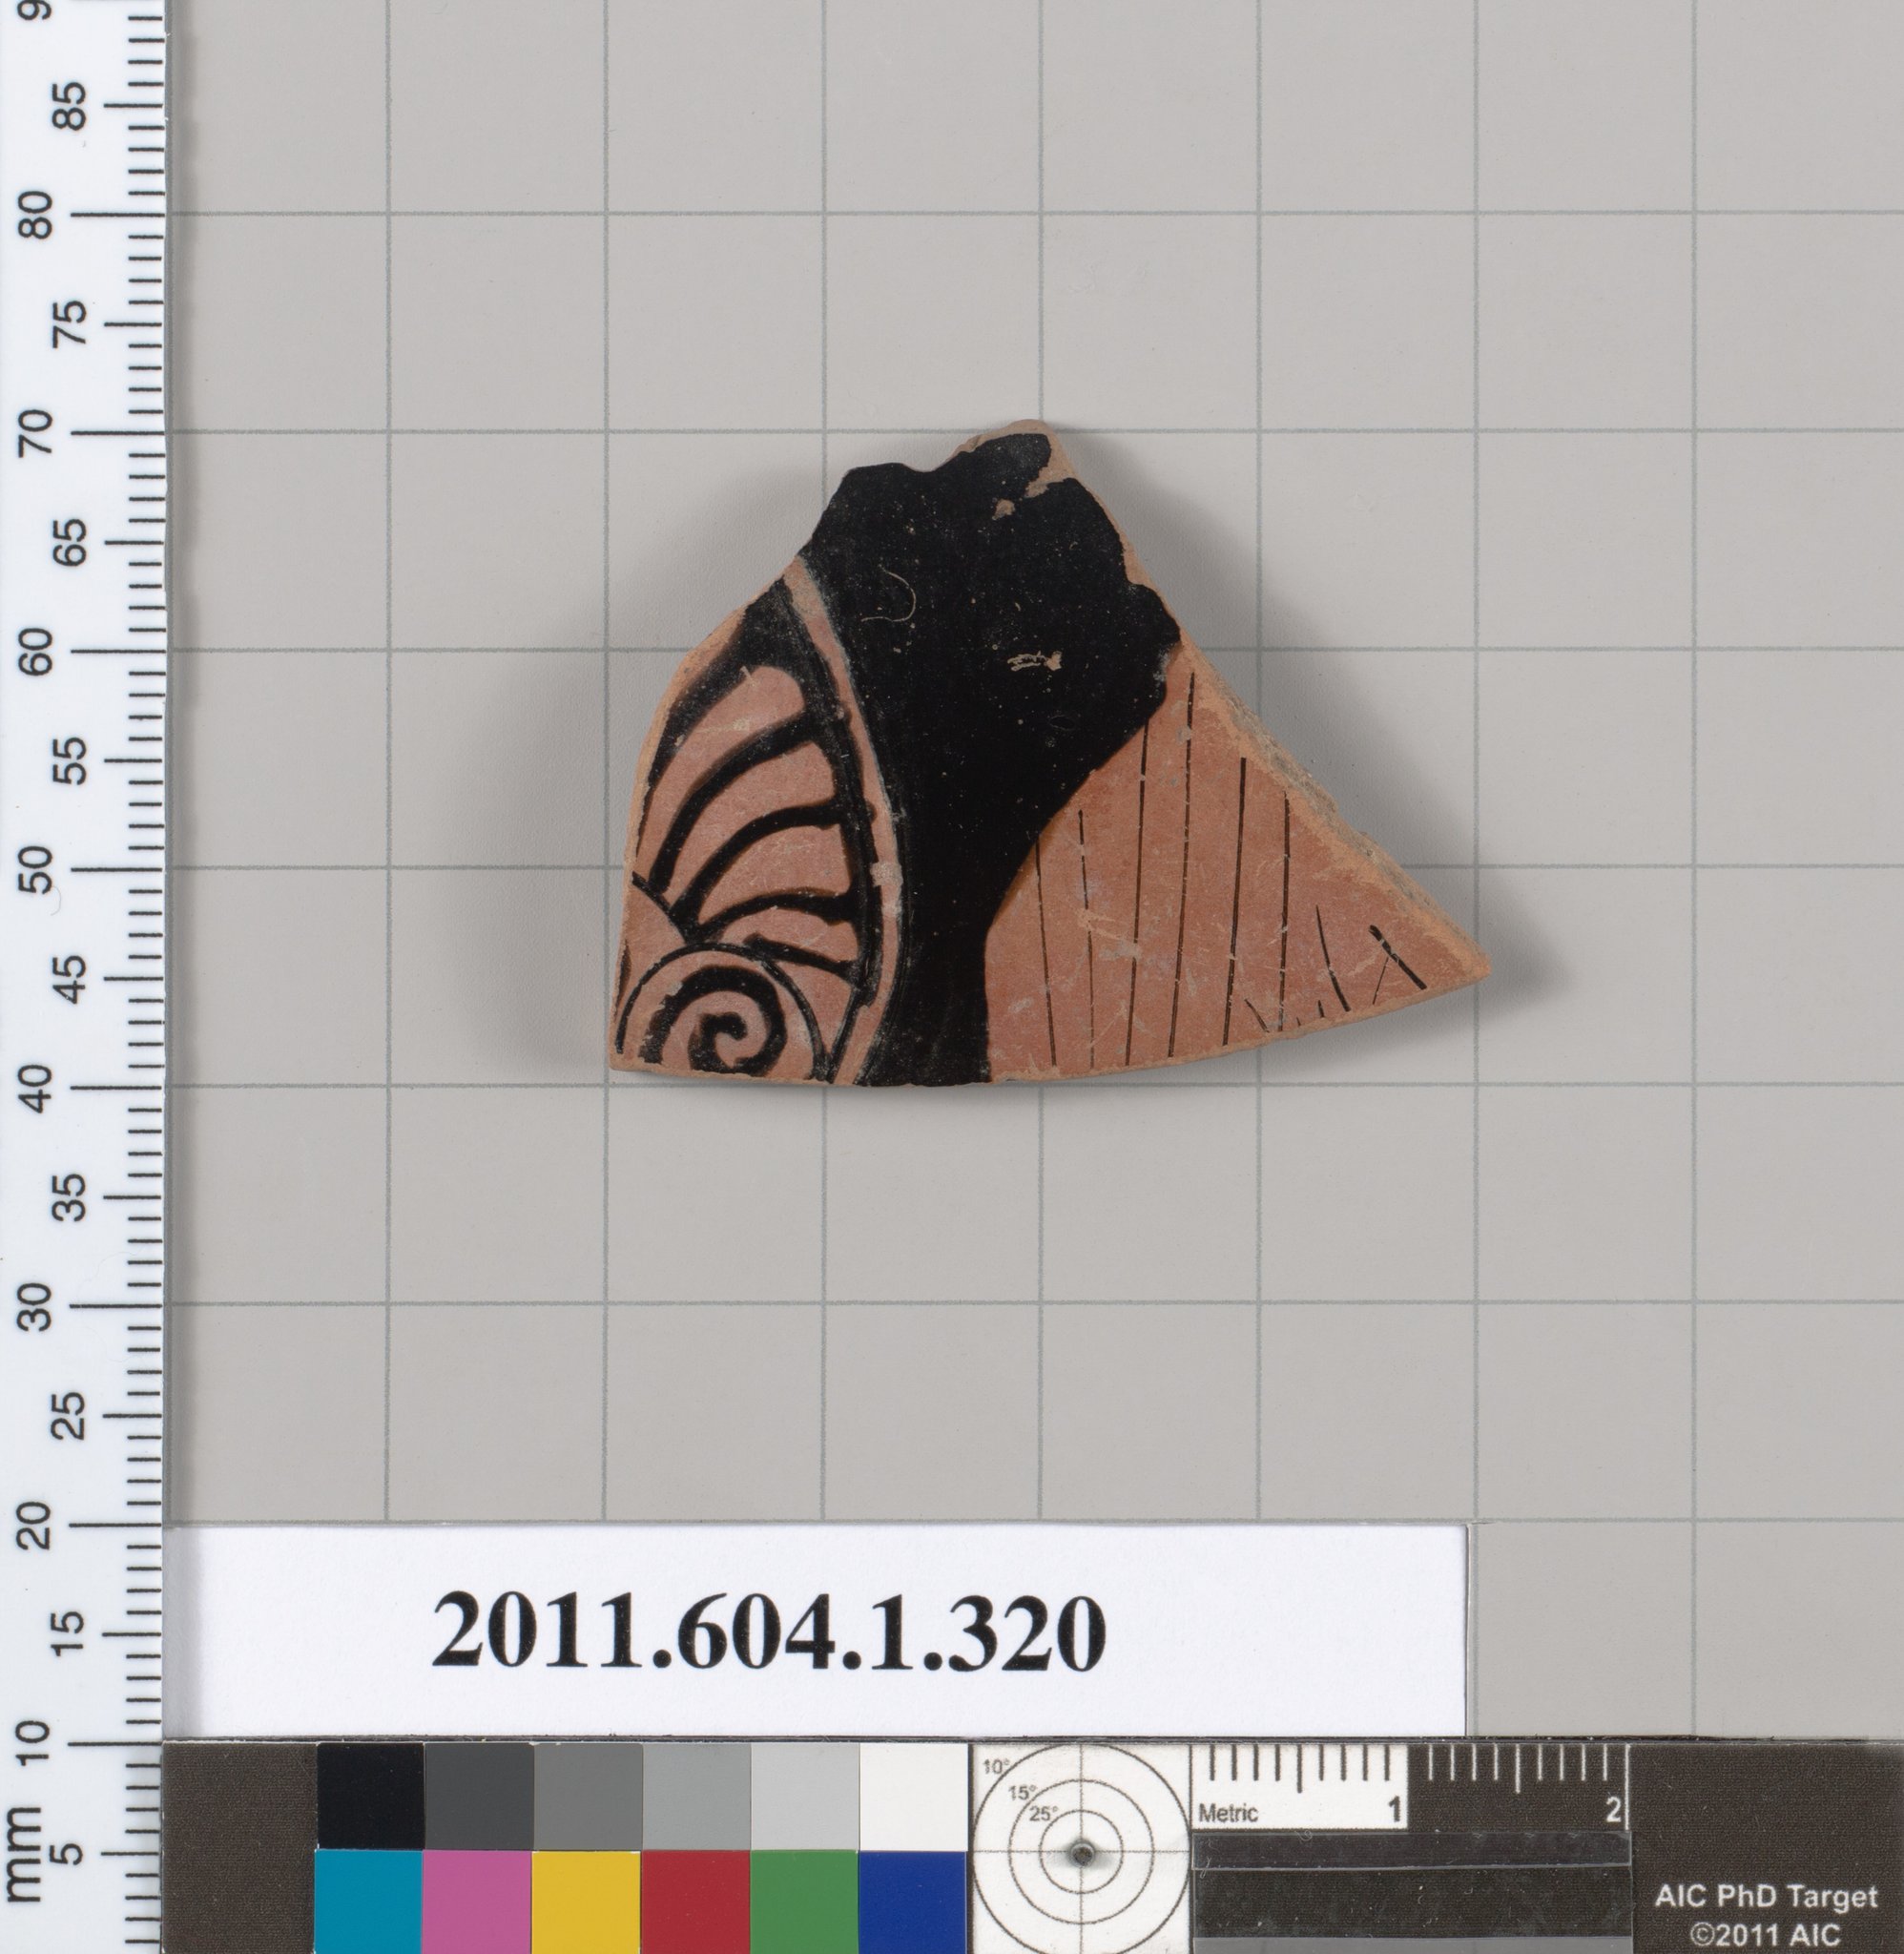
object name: kylix fragment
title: Terracotta fragment of a kylix (drinking cup)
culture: greek, attic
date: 475-451 BCE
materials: terracotta